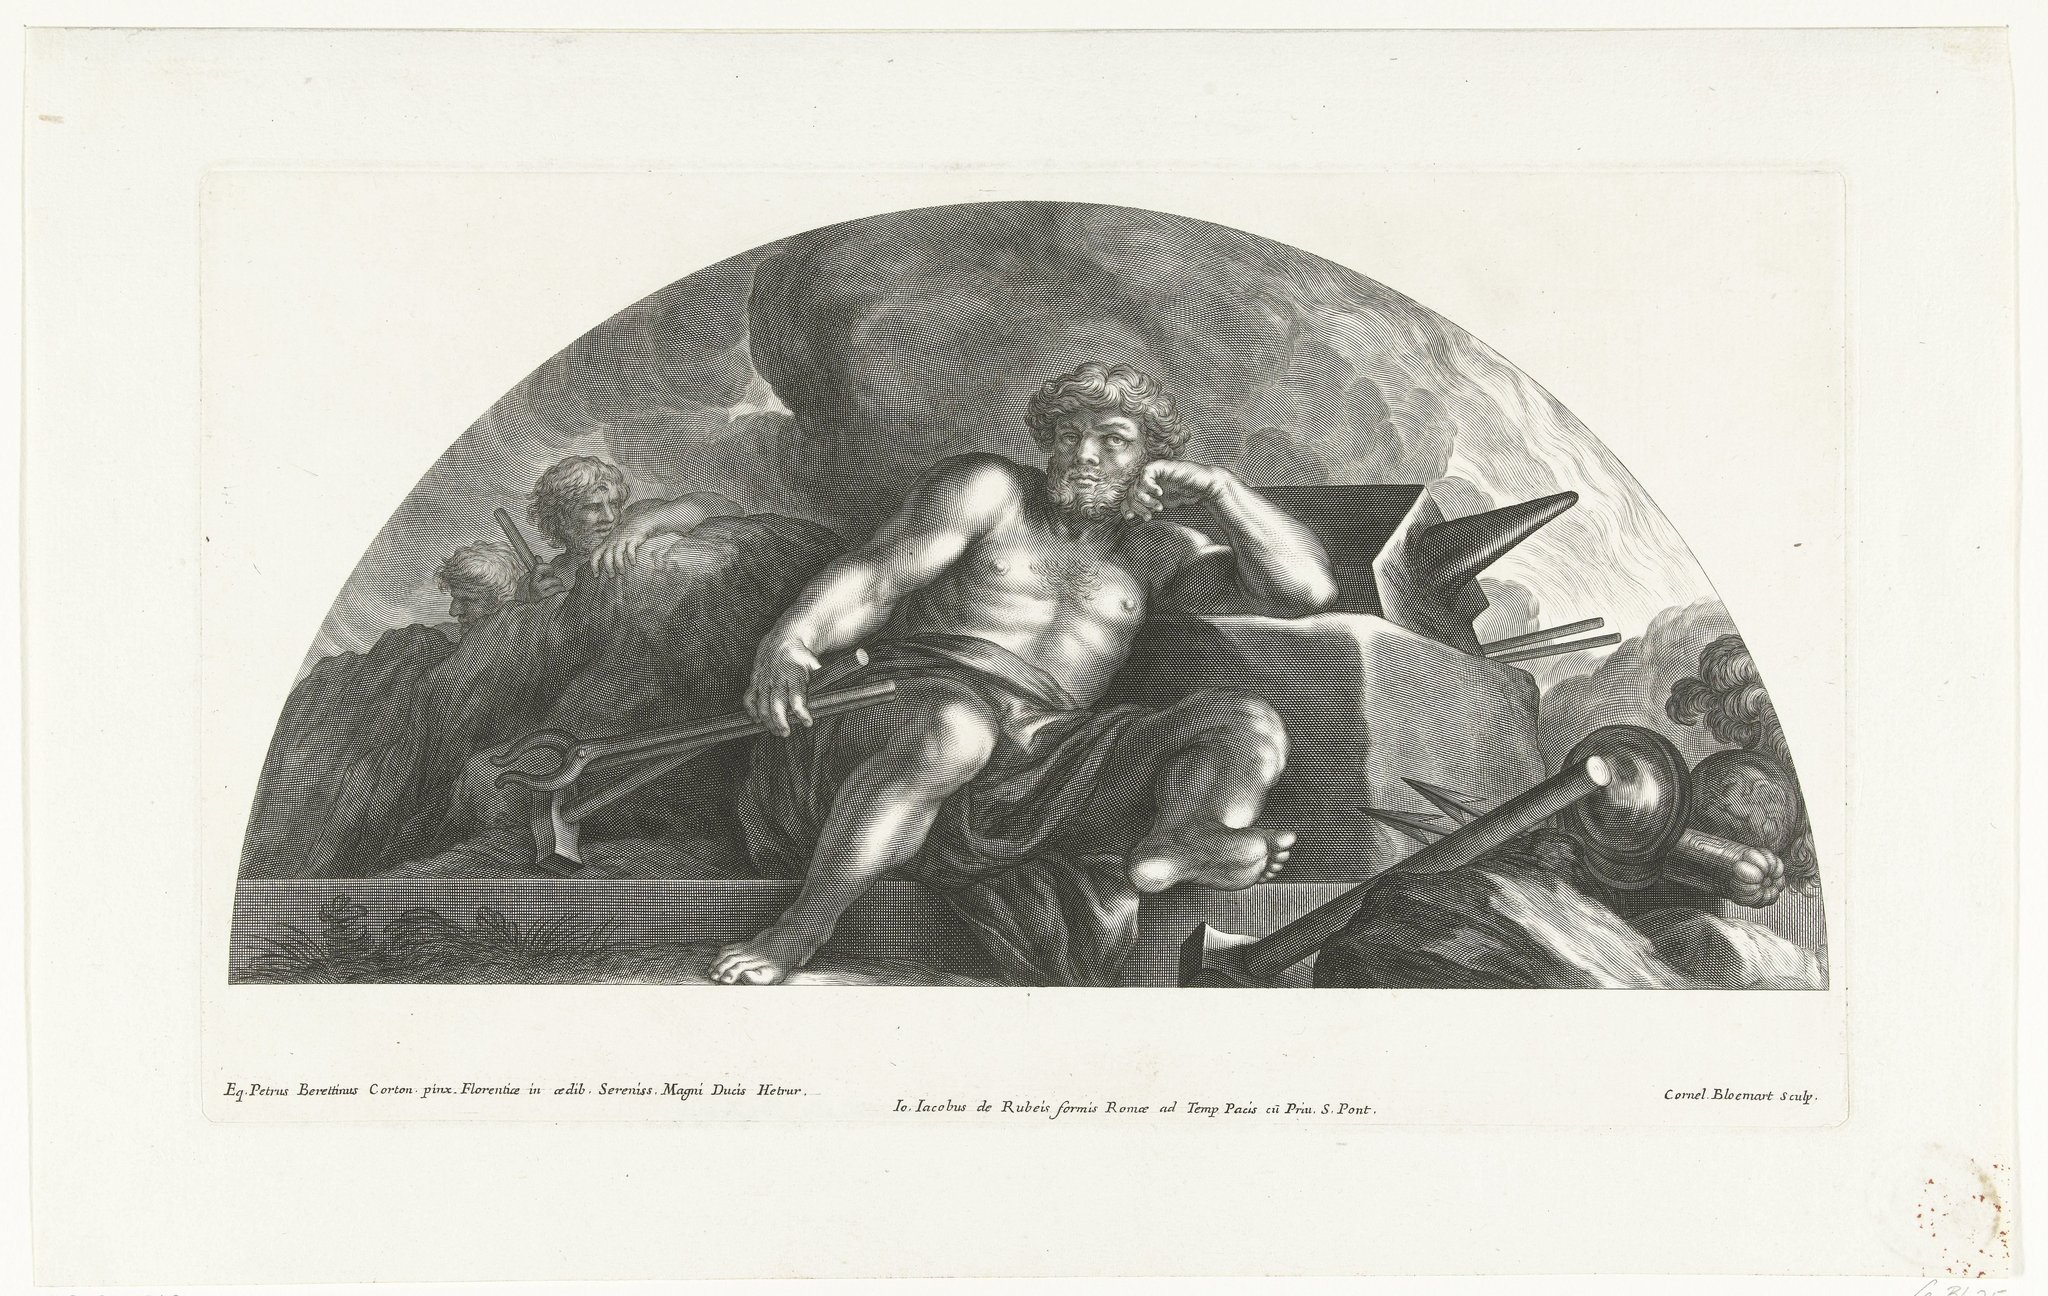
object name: print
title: Vulcanus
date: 1637-1692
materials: paper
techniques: engraving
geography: rome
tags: (story of) vulcan (hephaestus)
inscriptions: collector's mark: Lugt 240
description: Vulcanus, god van het vuur en smid onder de goden, zit op een steen voor de krater van een vulkaan. Hij houdt een hamer en een vuurtang in zijn hand. Prent uit een serie van vier prenten naar fresco's van Pietro da Cortona.